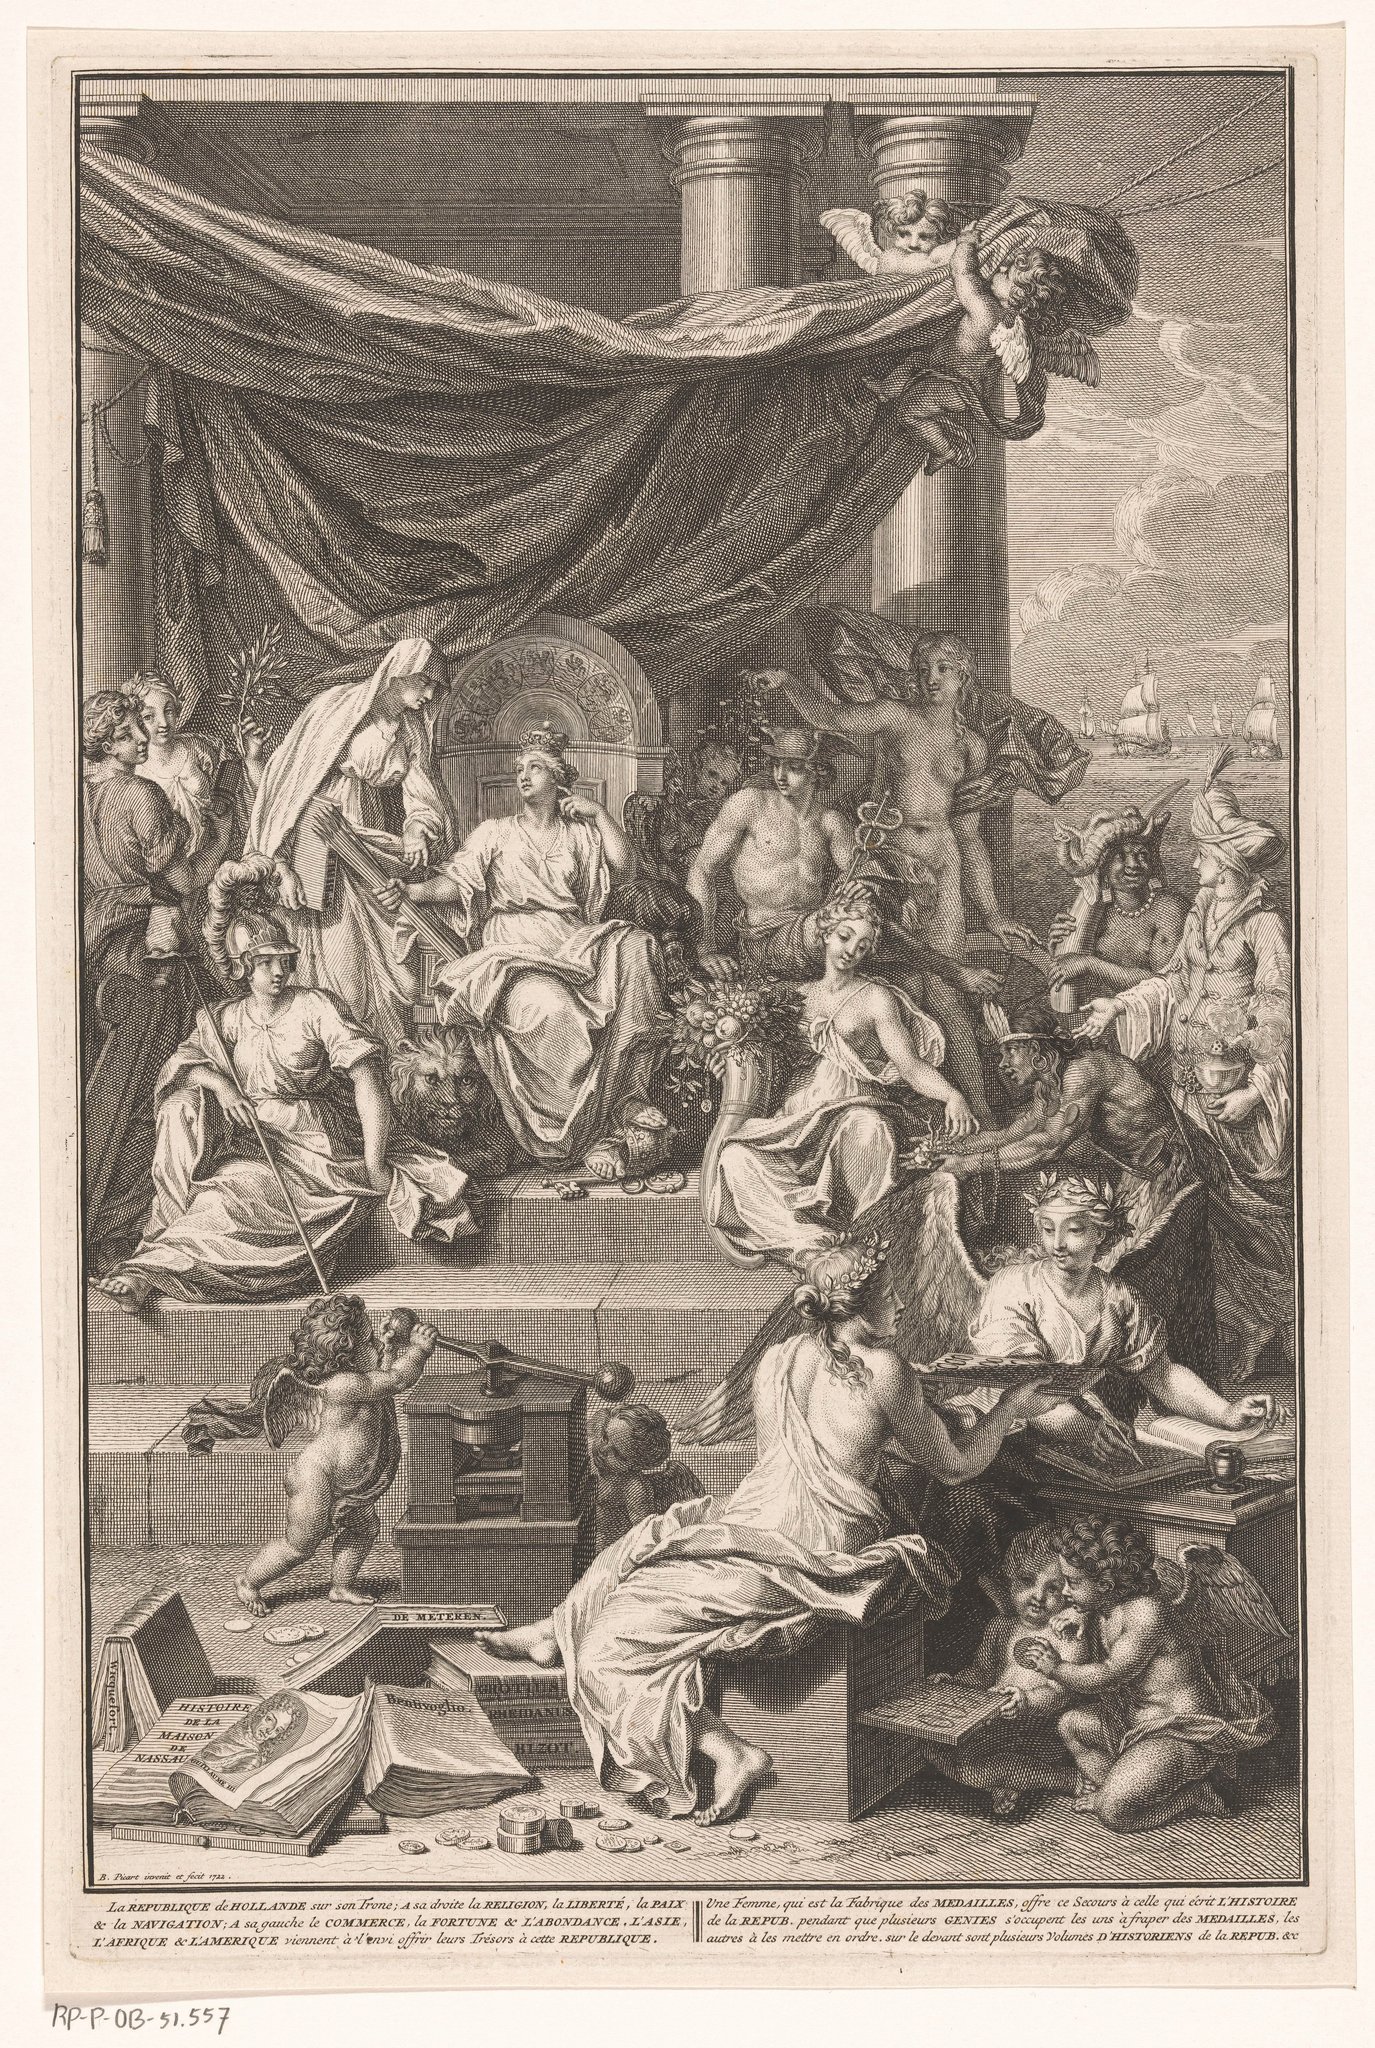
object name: print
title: Titelpagina voor: J. Le Clerc, Histoire des Provinces-Unies des Pays-Bas, 1723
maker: bernard picart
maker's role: draughtsman, print maker, publisher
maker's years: 1673-1733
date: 1722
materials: paper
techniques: engraving, etching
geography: amsterdam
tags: the hague, william iii (prince of orange and king of england, scotland, and ireland), 'navigatione' (ripa), personifications of countries, nations, states, districts, etc., symbols, allegories of peace, 'pax'; 'pace' (ripa), fidelity; 'fedeltà' (ripa), medal (considered as a piece of sculpture, regardless of its specific function), abundance; 'abondanza', 'abondanza maritima' (ripa), luck, fortune, lot; 'fato', 'fortuna', 'fortuna aurea', 'fortuna buona', 'fortuna pacifica overo clemente', 'sorte' (ripa), 'historia'; 'historia' (ripa), freedom, liberty; 'libertà' (ripa), allegory of trade; 'commertio della vita humana' (ripa), continents represented allegorically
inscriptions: collector's mark: Lugt 2228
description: De personificatie van de Republiek der Zeven Verenigde Nederlanden zit op een troon. Ze wordt geflankeerd door Geloof, Vrede, Zeevaart, Vrijheid, Koophandel (gepersonifieerd door Mercurius), Geluk en Overvloed. De personificaties van de vier werelddelen bieden haar geschenken aan. Rechts op de voorgrond Geschiedenis die in haar boek schrijft. Een vrouw toont haar de medailles die zojuist door putti vervaardigd zijn. Links op de voorgrond een opengeslagen boek met het portret van Willem III. In de marge een zesregelig onderschrift, in twee kolommen, in het Frans.